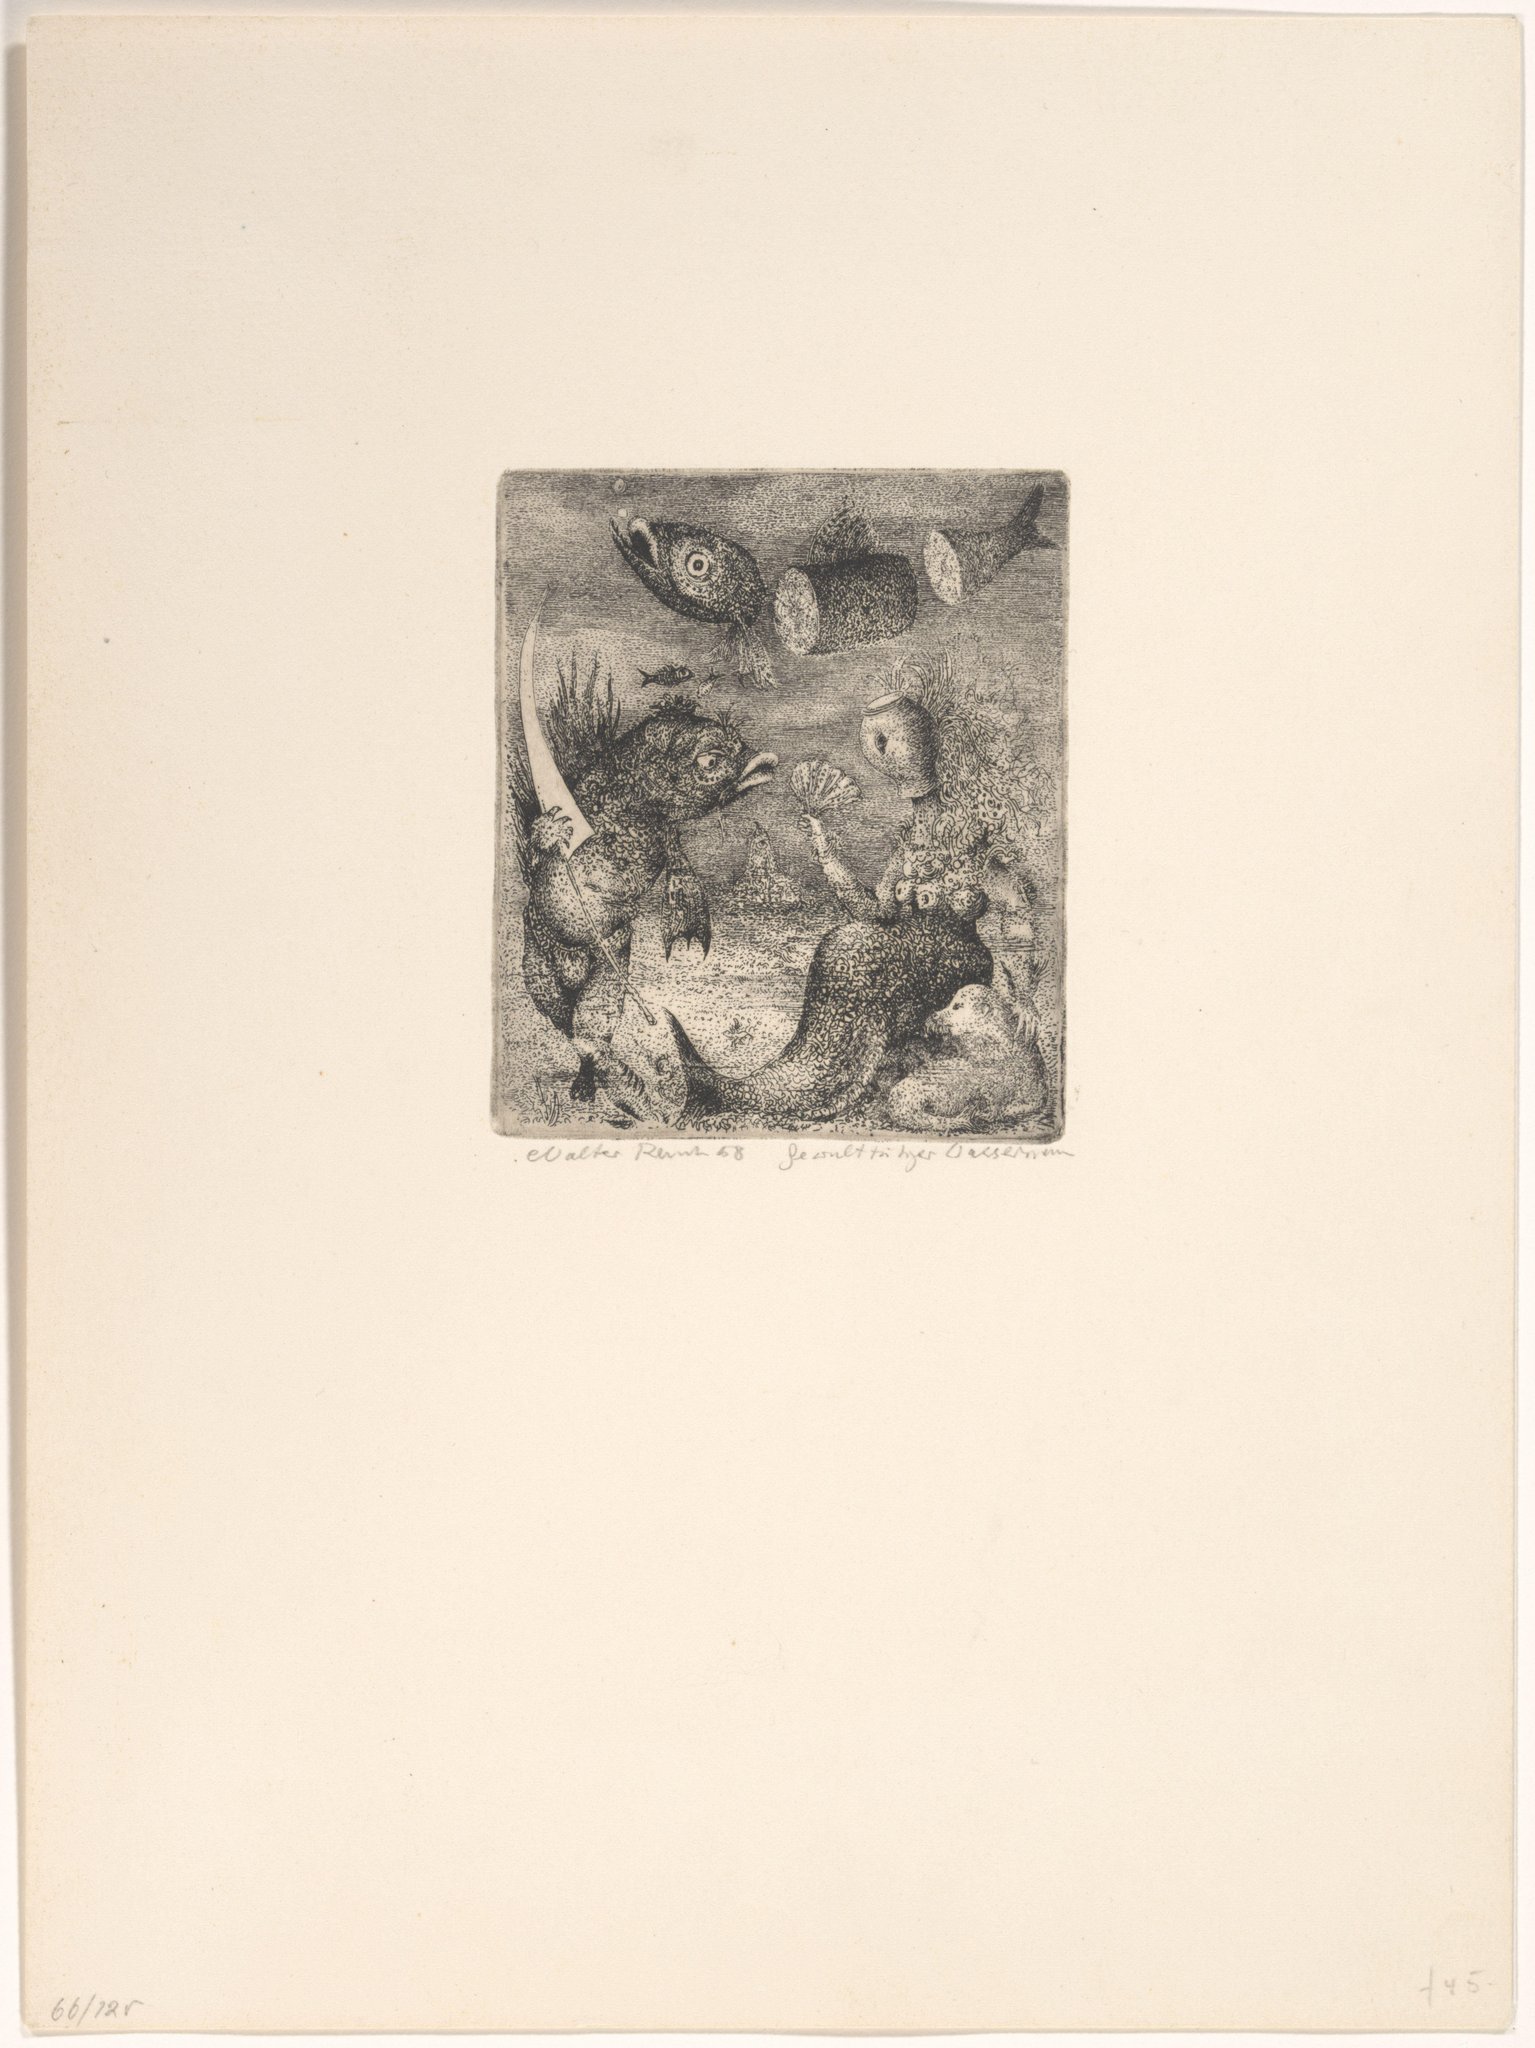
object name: print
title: Zeemeermin en uiteenvallende vis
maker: walter rauch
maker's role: print maker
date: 1958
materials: paper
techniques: etching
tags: merman - aa - mermaid, siren, fishes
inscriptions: title: ‘Ge[...]ttinger [...]asser[...]’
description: Rechts zit een zeemeermin met een pot op haar hoofd. Ze legt haar hand op de zeehond die naast haar zit. Voor haar staat een vis die een zwaard vasthoudt met een van zijn vinnen. Bovenaan drijft een vis die in drie stukken uiteenvalt.